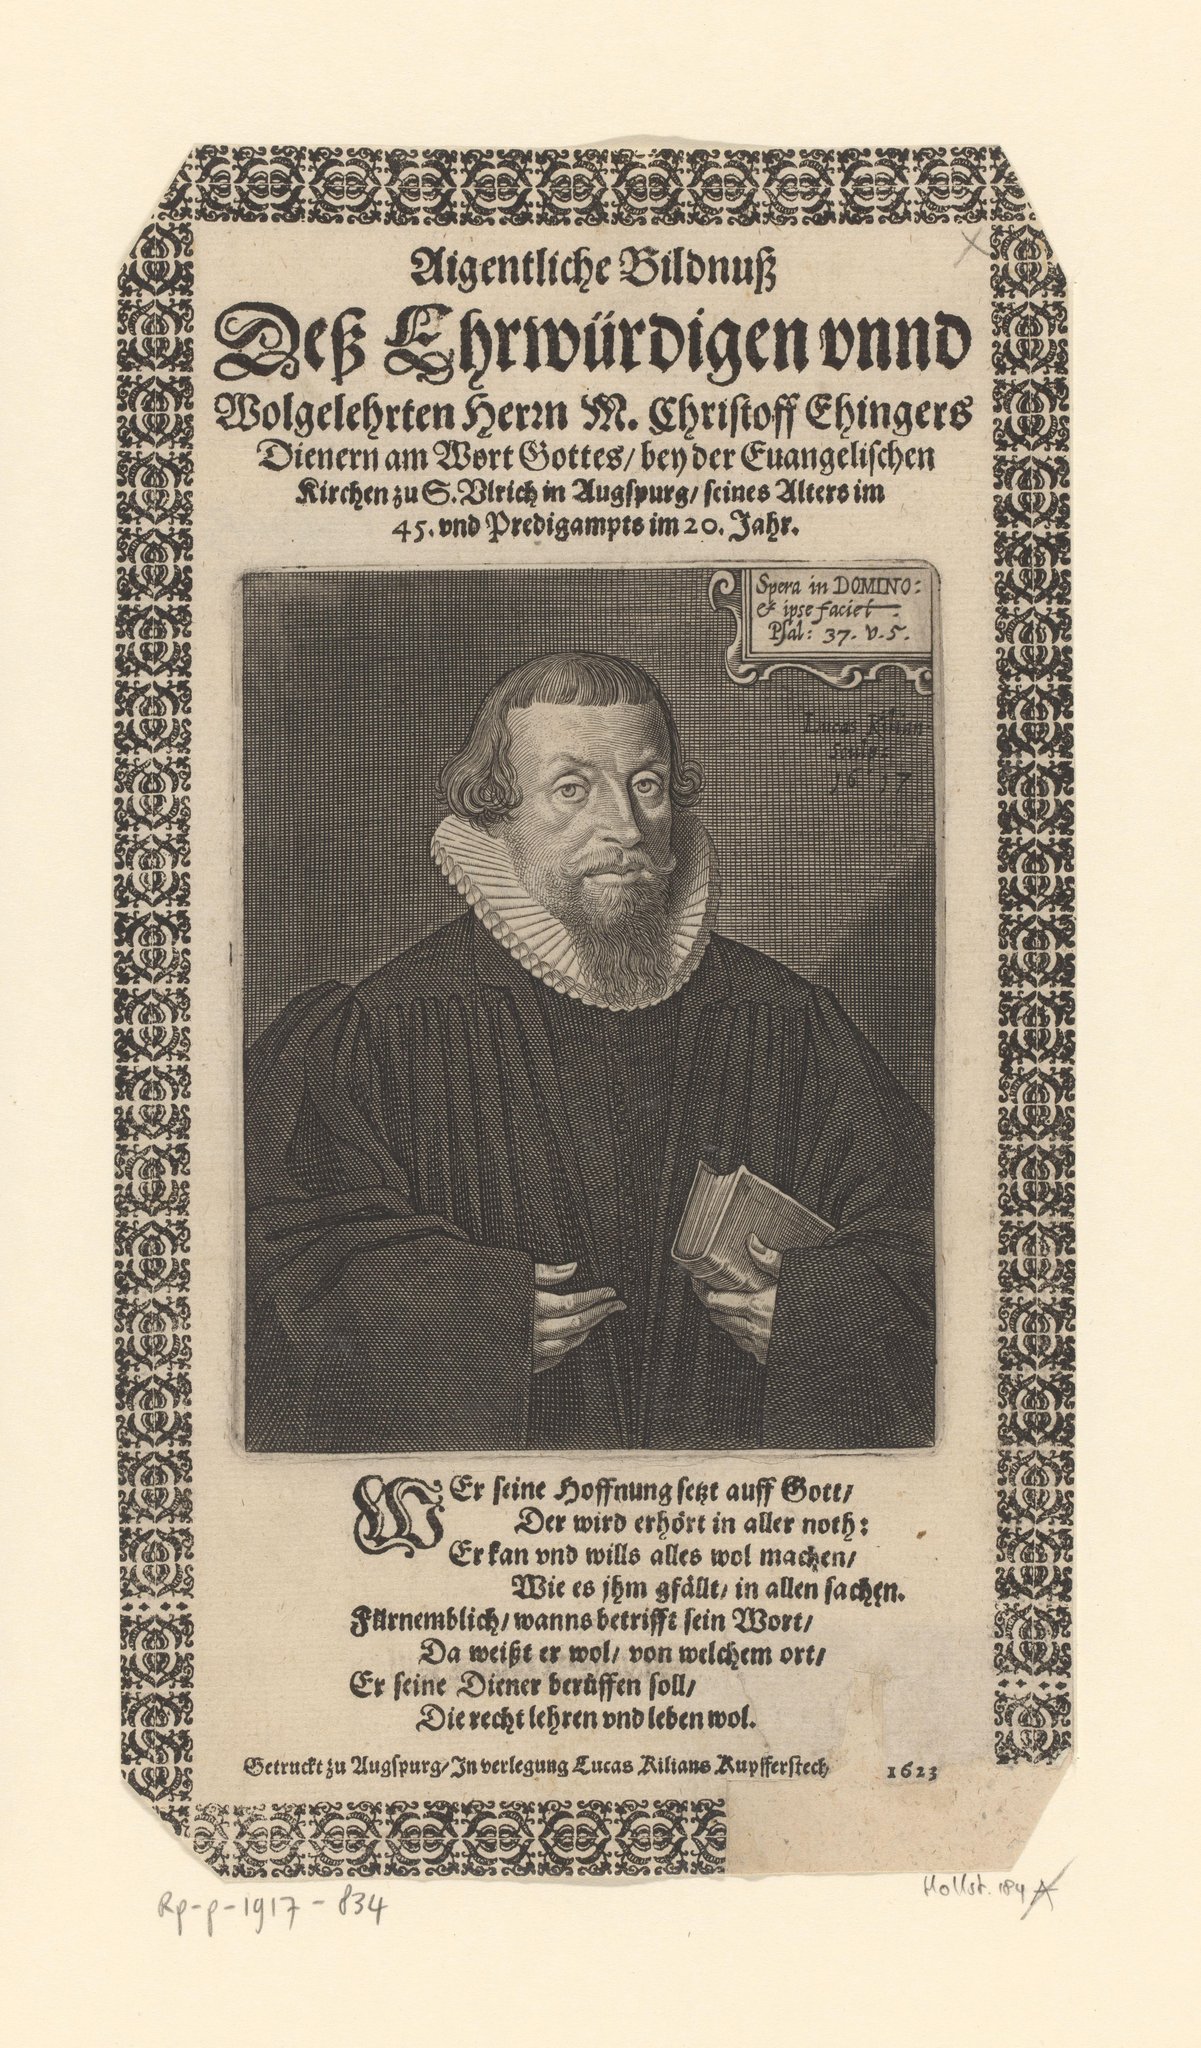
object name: print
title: Portret van Christoph Ehinger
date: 1617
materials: paper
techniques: engraving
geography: augsburg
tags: augsburg, theologian, historical persons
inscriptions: collector's mark: Lugt 2228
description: Tekst in het Latijn in boekdruk binnen een omkadering van fleurons.